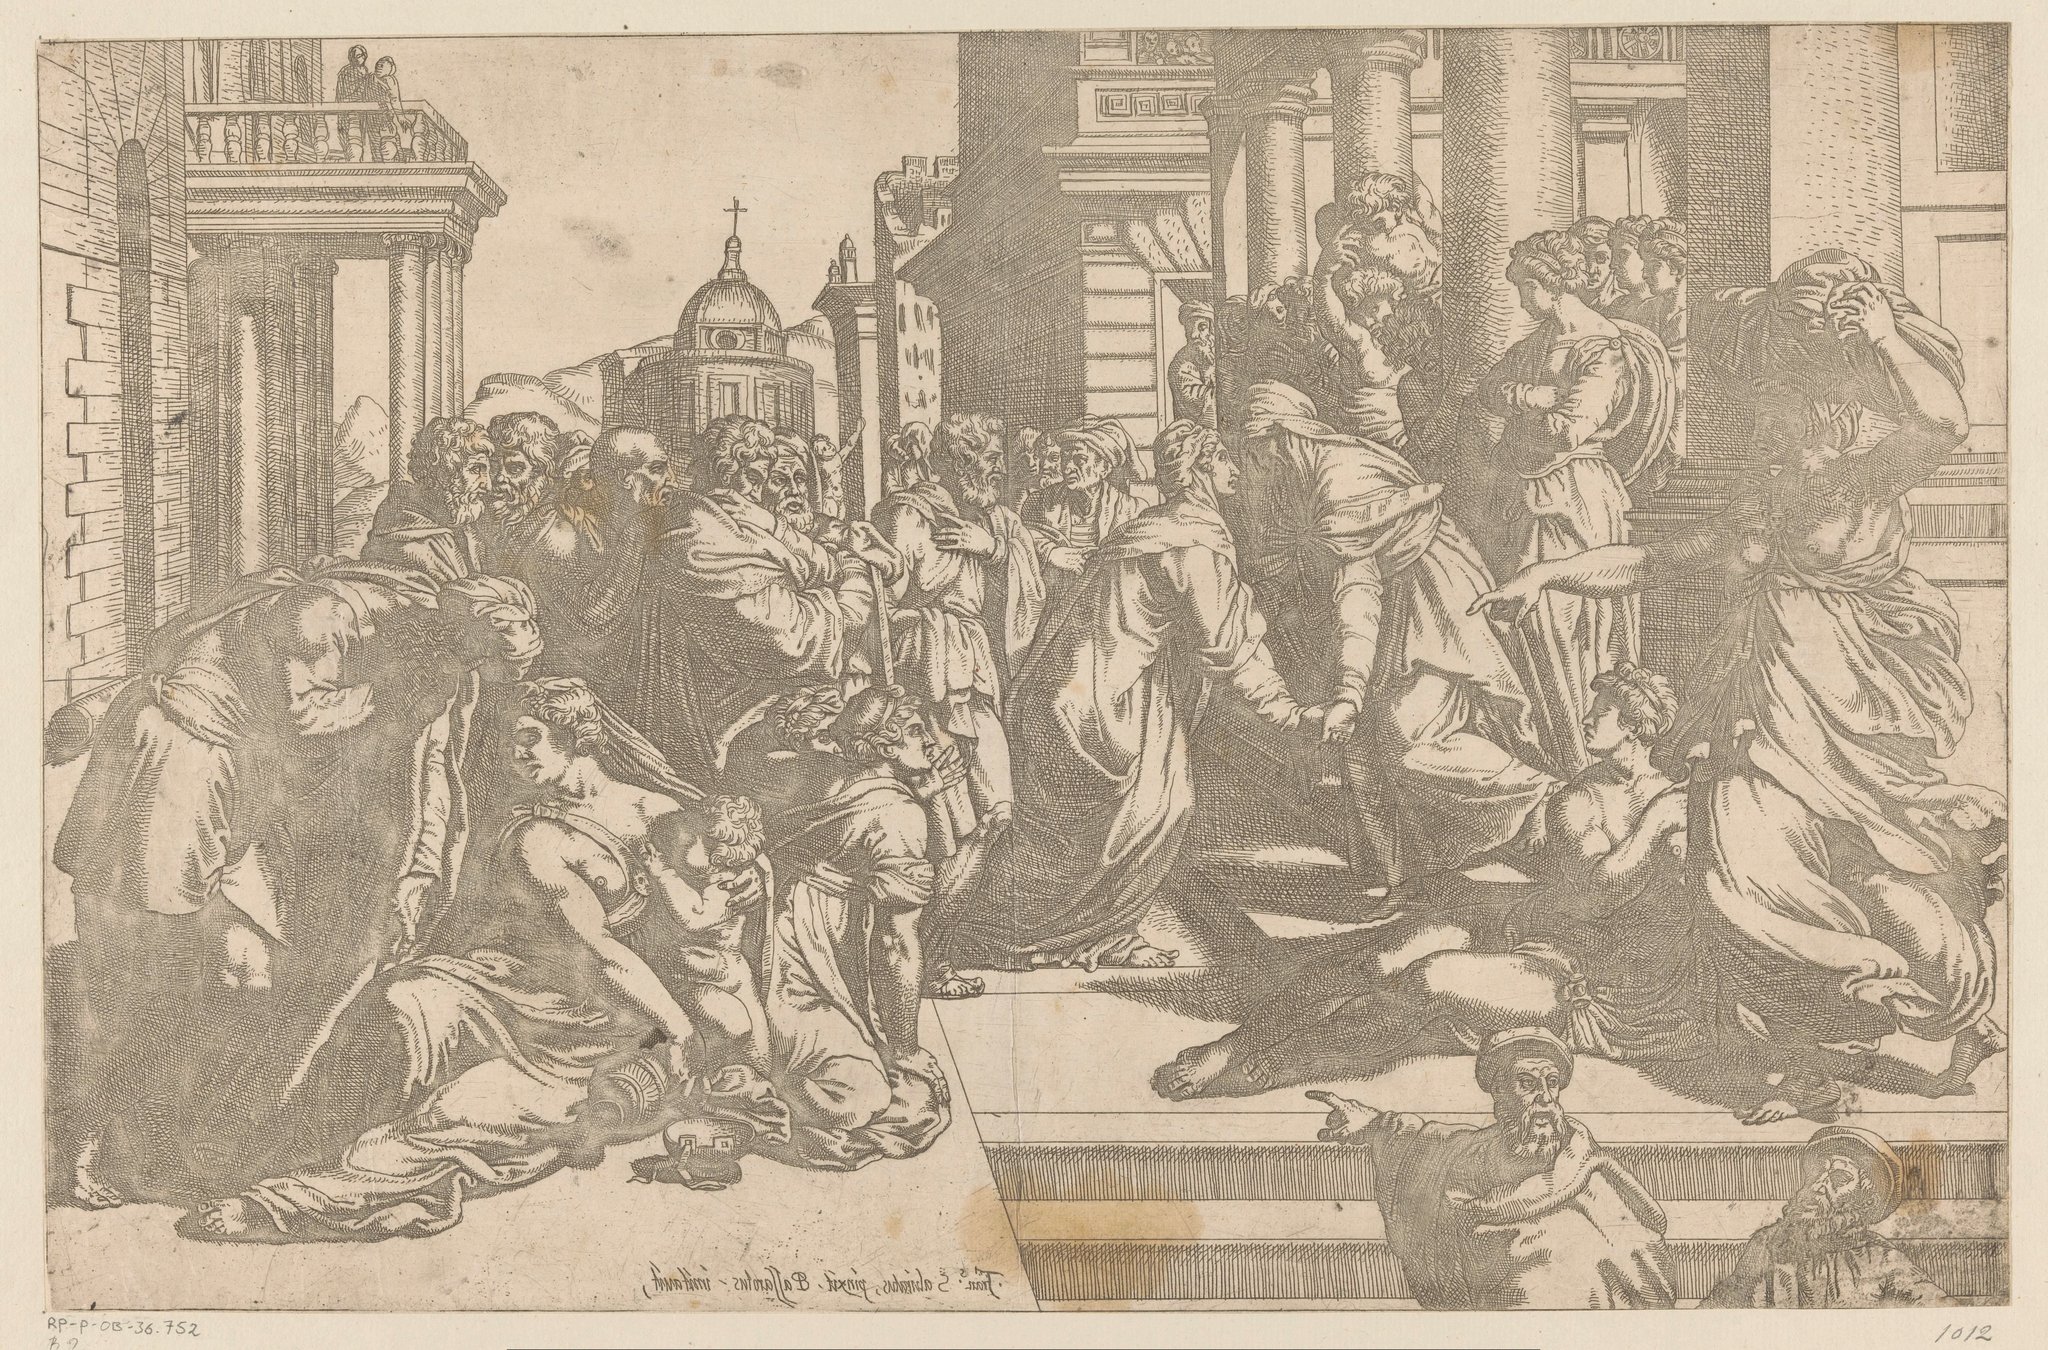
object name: print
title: Visitatie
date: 1539-1592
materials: paper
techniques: etching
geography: italy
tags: visitation (possibly joseph and/or zacharias present) (luke 1:39-56)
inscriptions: collector's mark: Lugt 240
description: Prent spiegelbeeldig naar een fresco door Francesco Salviati in de Chiesa di San Giovanni Decollato te Rome. Het spiegelbeeldige opschrift doet vermoeden dat het gaat om een tegendruk, al wordt dit door o.a. het British Museum tegengesproken.